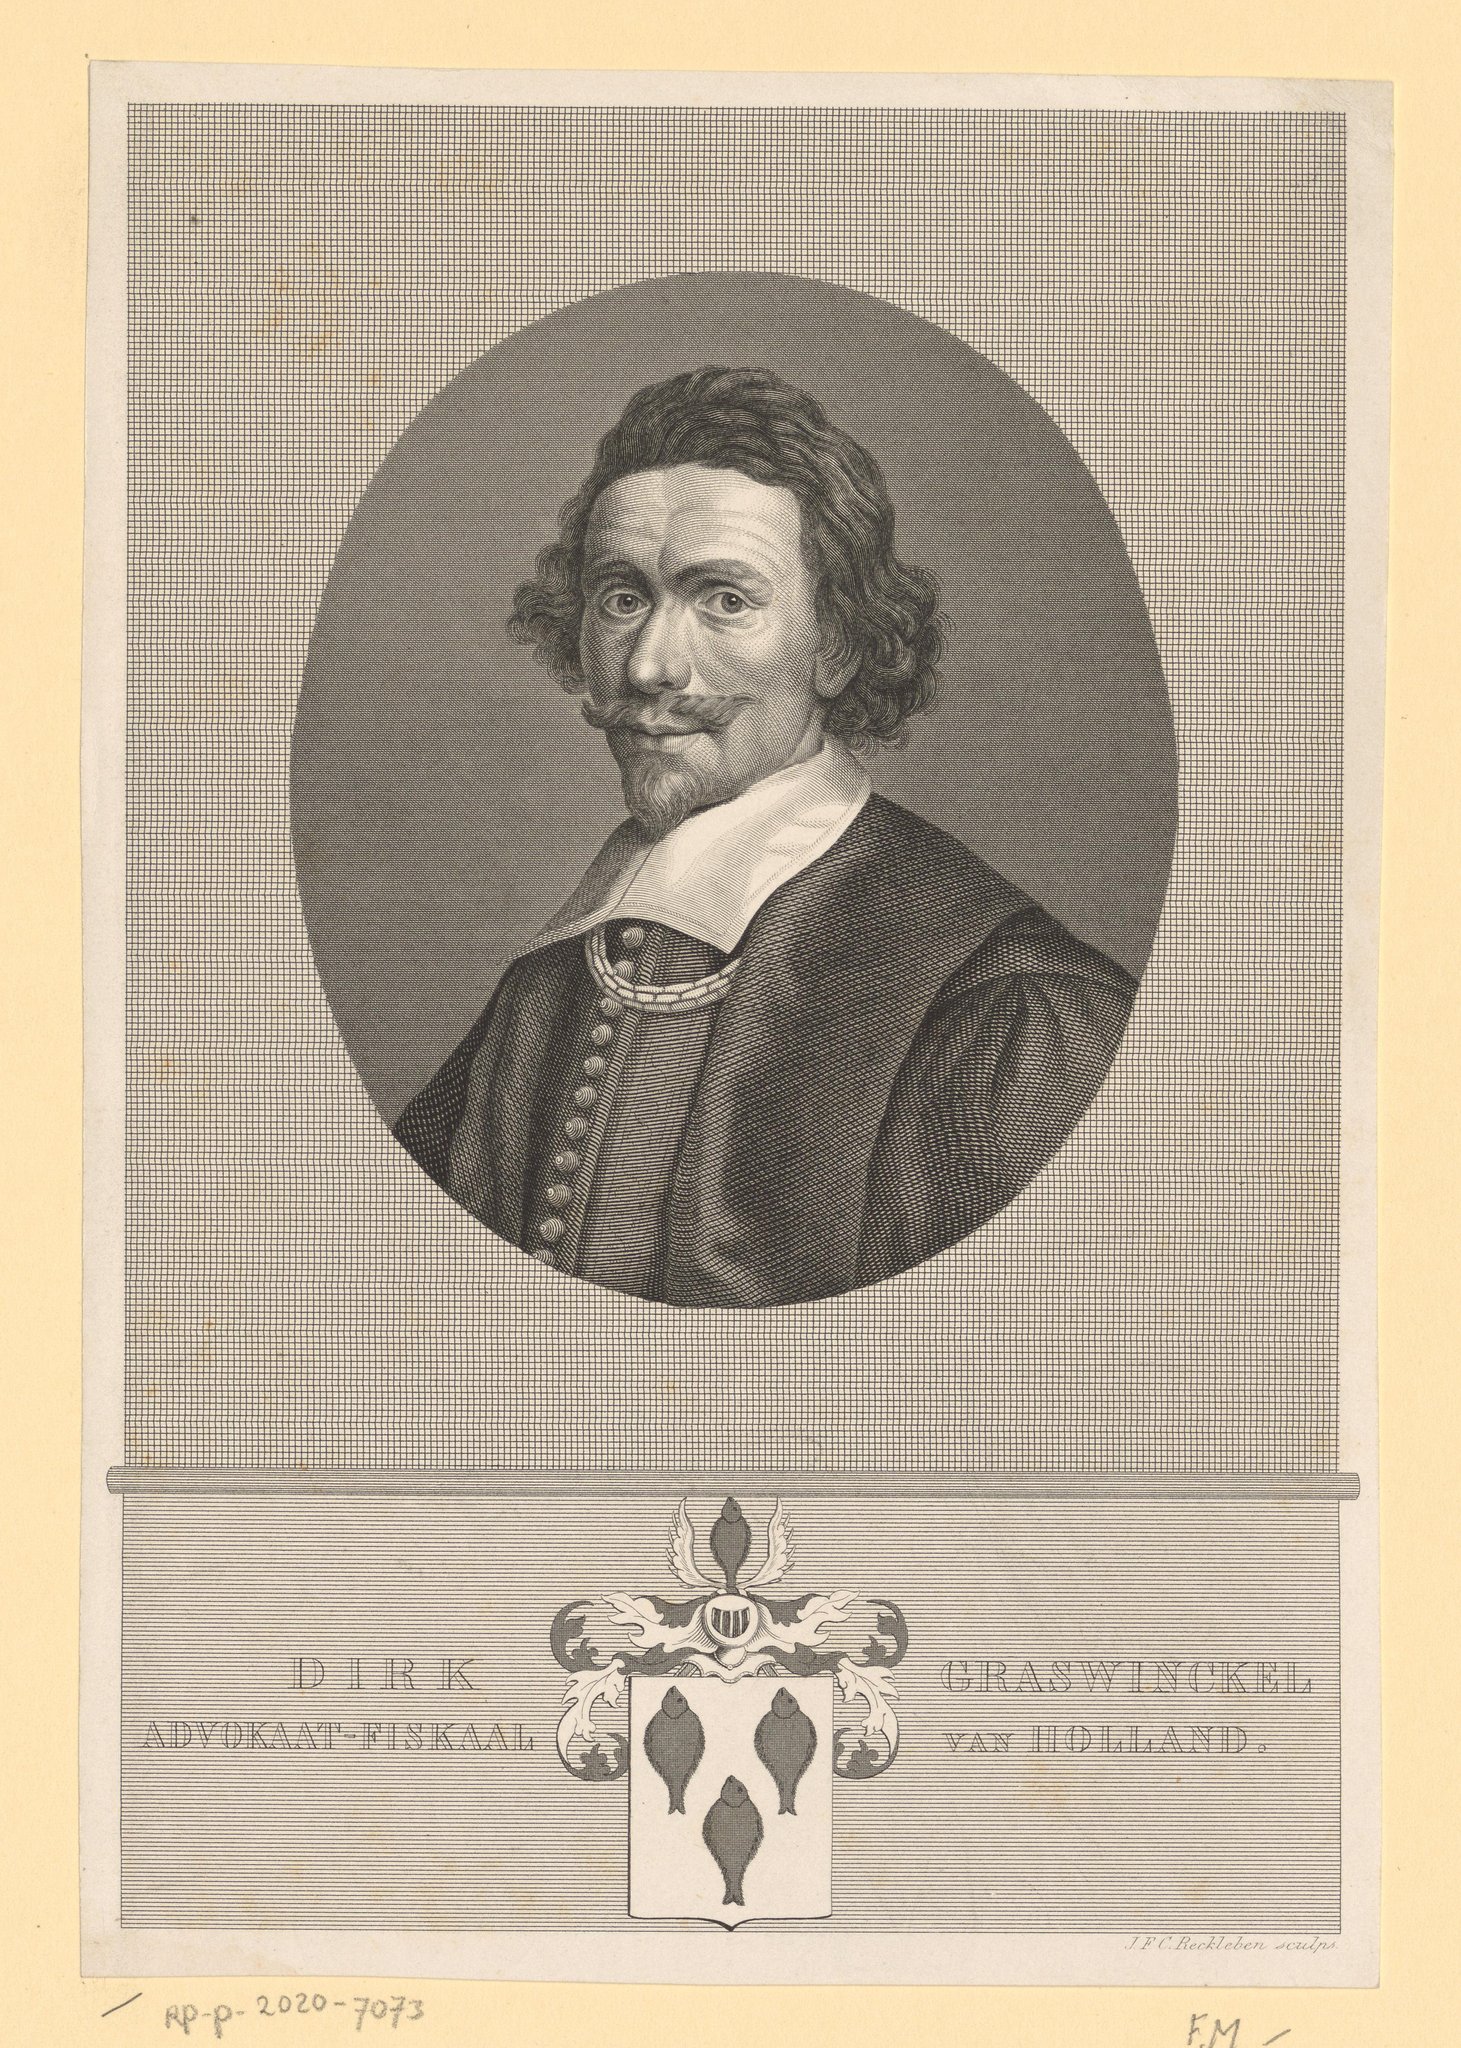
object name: book illustration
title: Portret van Theodorus Johannes Dirk Graswinckel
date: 1868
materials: paper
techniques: engraving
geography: amsterdam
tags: delft, mechelen, theodorus johannes dirk graswinckel, historical persons, writer, poet, author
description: Prent uit: Arend, Johannes Pieter. Algemeene geschiedenis des vaderlands van de vroegste tijden tot op heden. 5 dln. Amsterdam: J. F. Schleijer, 1868, dl. 4, p. 8.